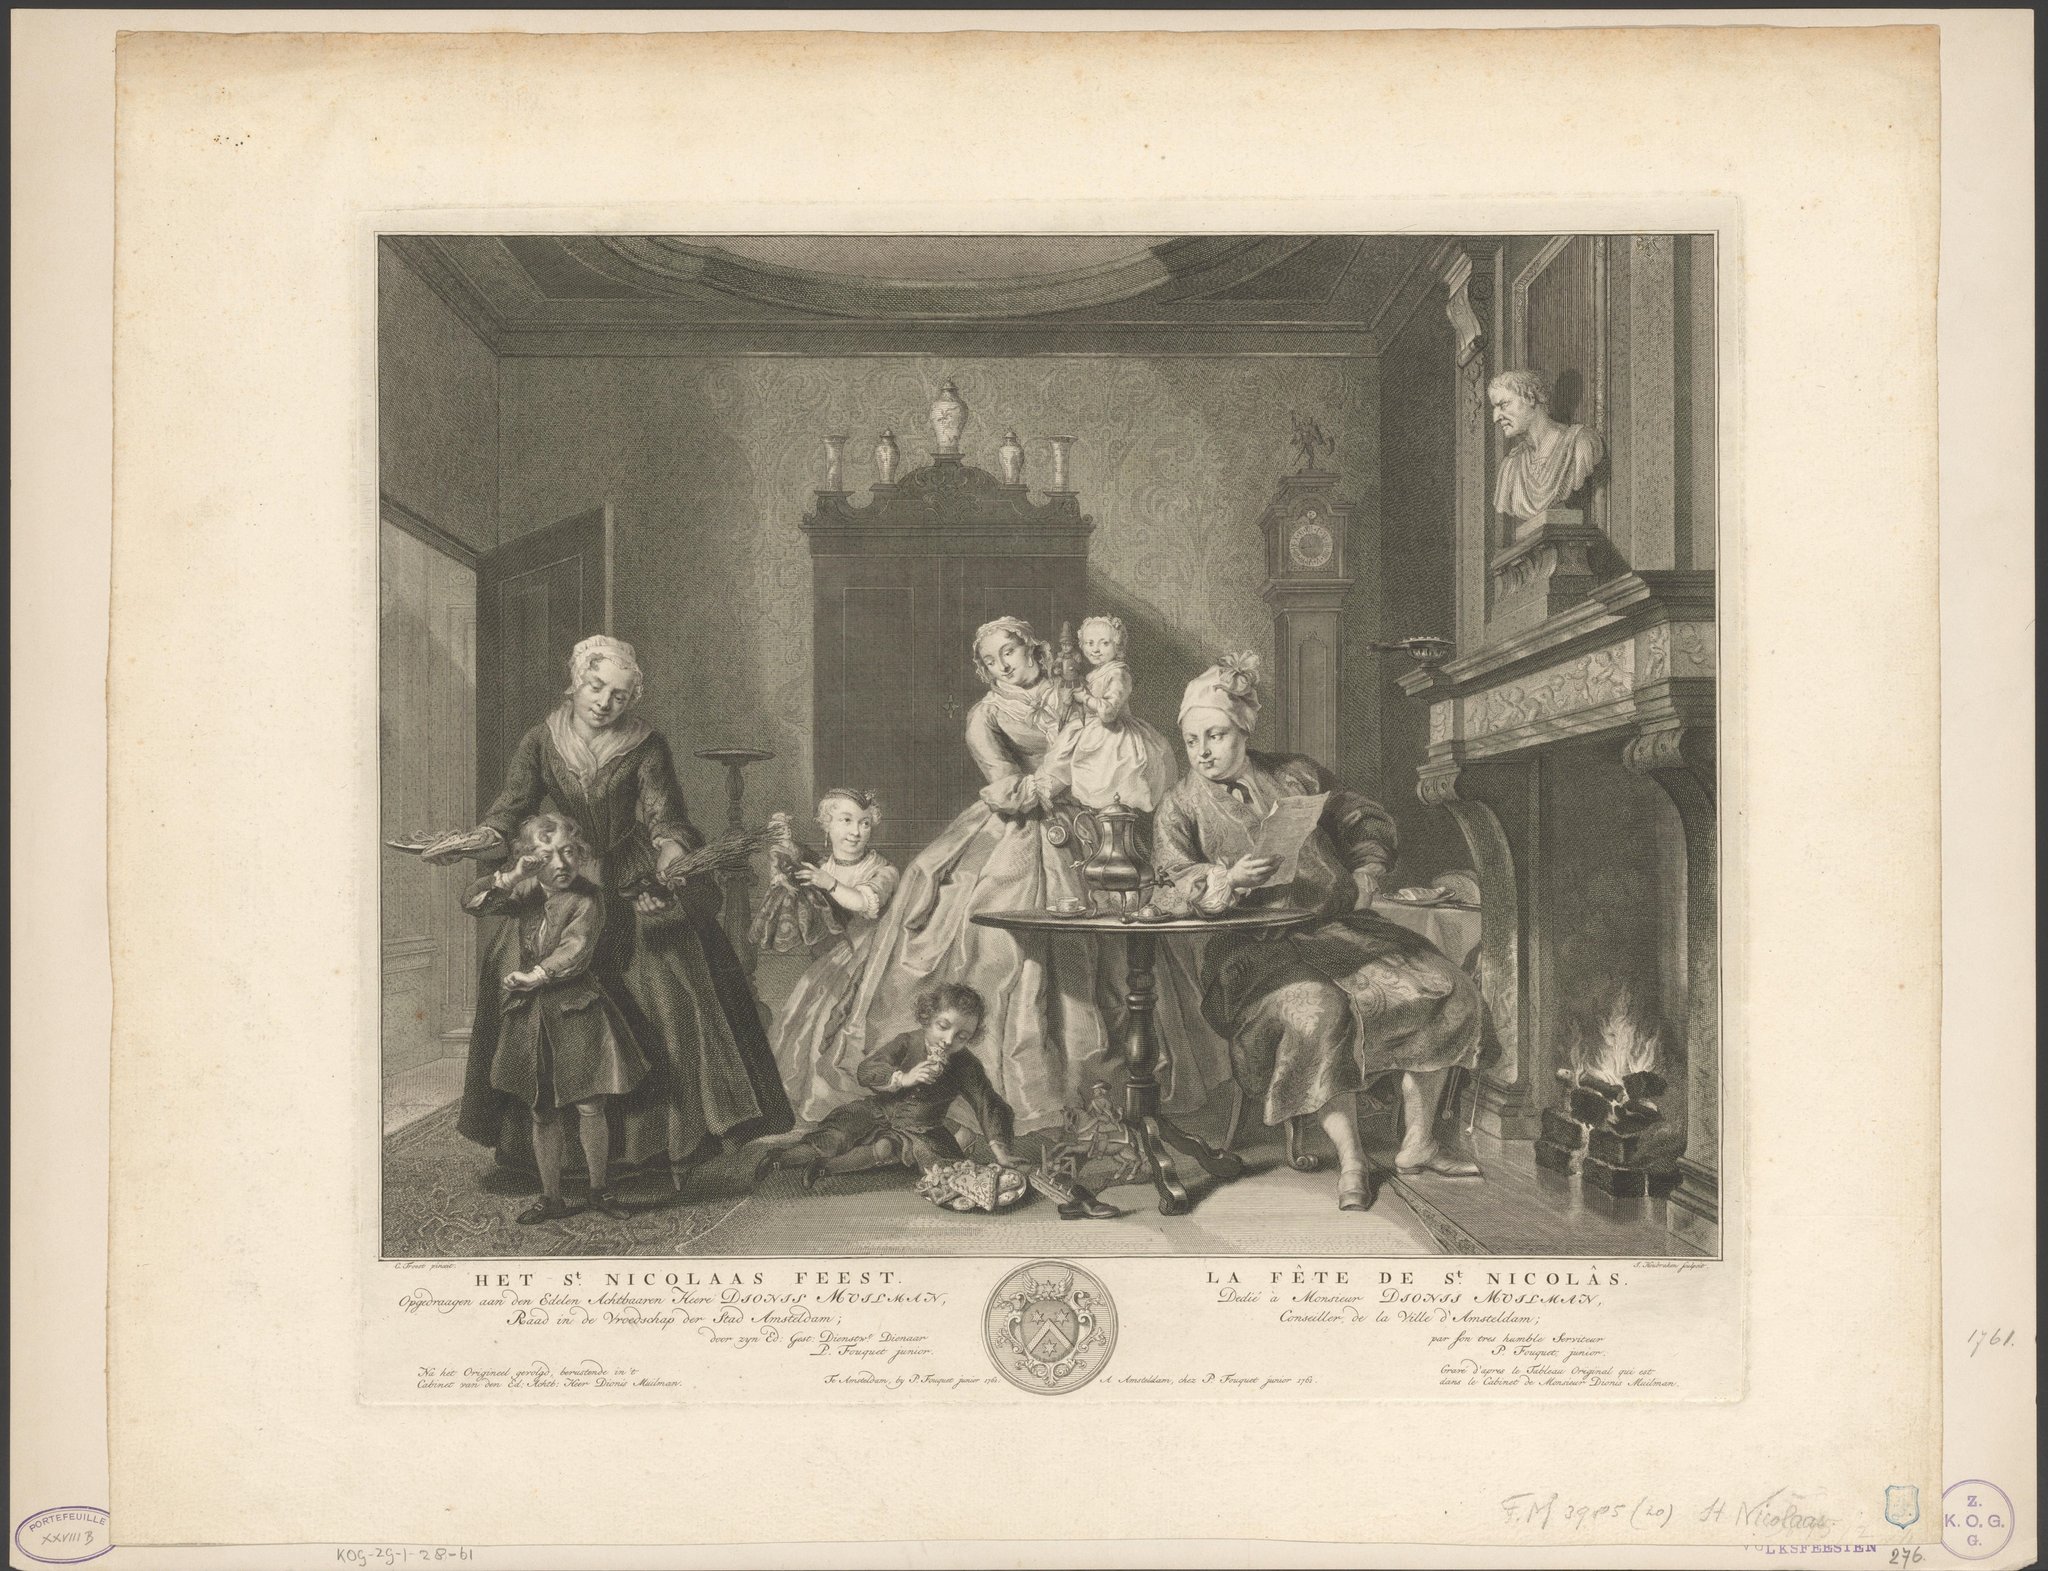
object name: print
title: Het St. Nicolaas feest / La fête de St. Nicolâs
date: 1761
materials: paper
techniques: engraving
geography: amsterdam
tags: cake, tart, pastry, open hearth, fire-place, (playing with) dolls, festivities on st. nicholas (eve) (december 5)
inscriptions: stamp, stamp, collector's mark: Lugt 963, collector's mark: Lugt 1641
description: In een interieur viert een gezin het Sint Nicolaasfeest. De vader zit bij de haard te lezen, achter hem laten twee dochters hun poppen zien die ze hebben gekregen. Op de grond snoept een kind met een schaal met koek en snoepgoed. Links een huilende jongen die alleen een roe heeft gekregen; de dienstmeid achter hem heeft zijn schoen met daarin de roe vast. Onderwerpsrubrieken binnen de Atlas Zeden en Gewoonten: Zeden en Gewoonten in Engeren Zin. Volksleven. Volksfeesten. St. Nicolaas.